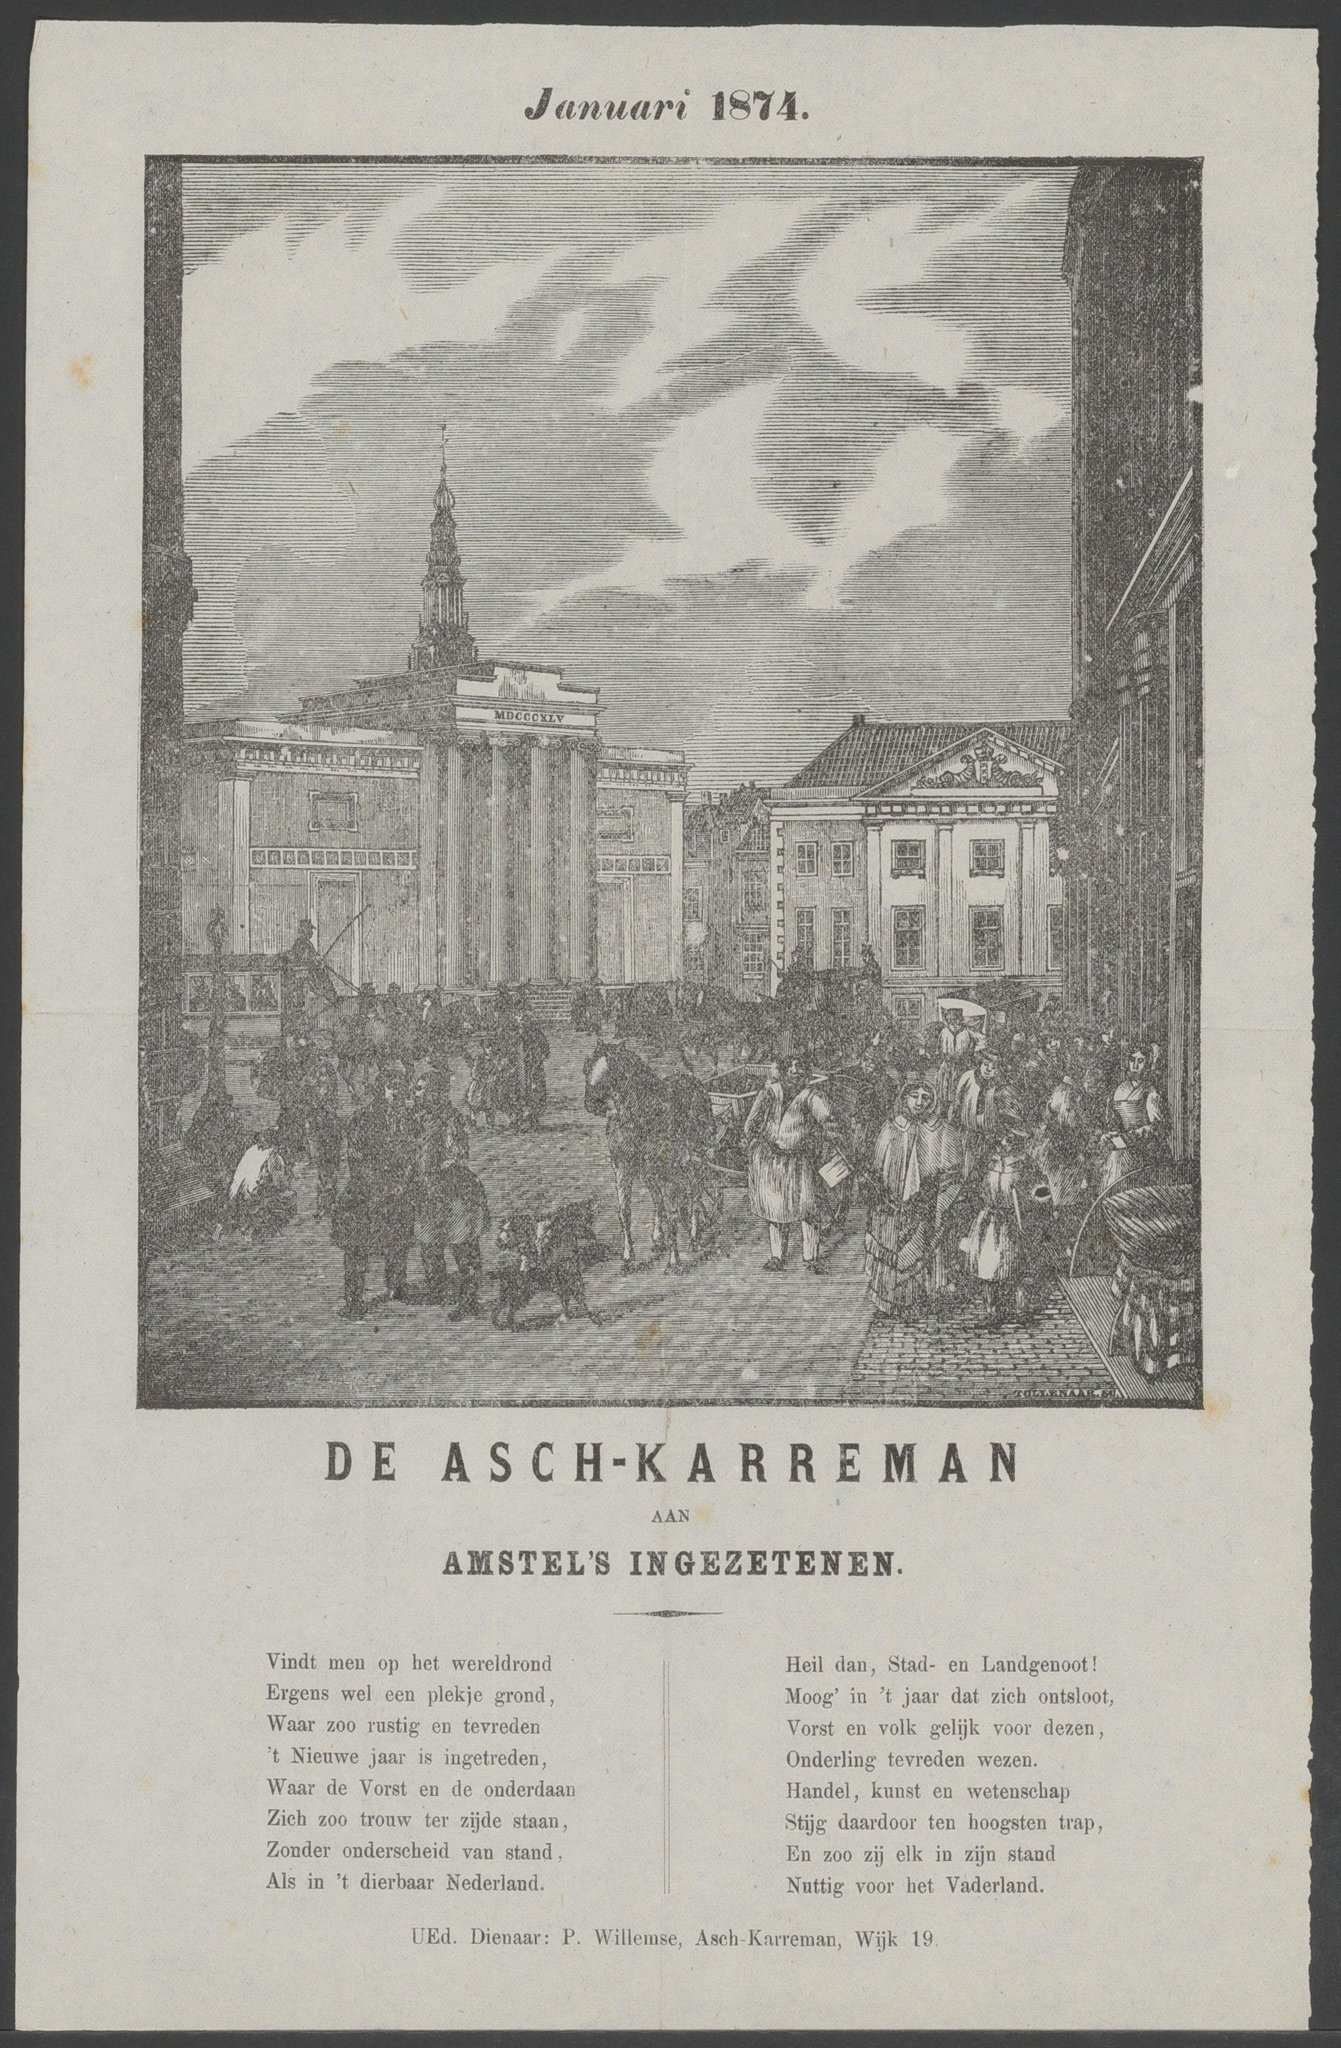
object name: print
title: De Asch-karreman aan Amstel's ingezetenen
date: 1873-1874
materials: paper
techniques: letterpress printing, engraving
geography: amsterdam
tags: street, garbage collection, amsterdam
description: Nieuwjaarswens van askarrenmannen (karrenman of vuilnisman) van Amsterdam voor het jaar 1874. Gezicht op de Dam met de Beurs van Zocher en het Commandantshuis te Amsterdam. Tussen het publiek de vuilnismannen met hun kar. Met gedicht in twee kolommen. Van de vuilniskarman in de wijk no. 19: P. Willemse. Onderwerpsrubrieken binnen de Atlas Zeden en Gewoonten: Zeden en gewoonten in engeren zin, Volksleven, Volksbladen, Nieuwjaars- en Kerstwenschen, Amsterdam.